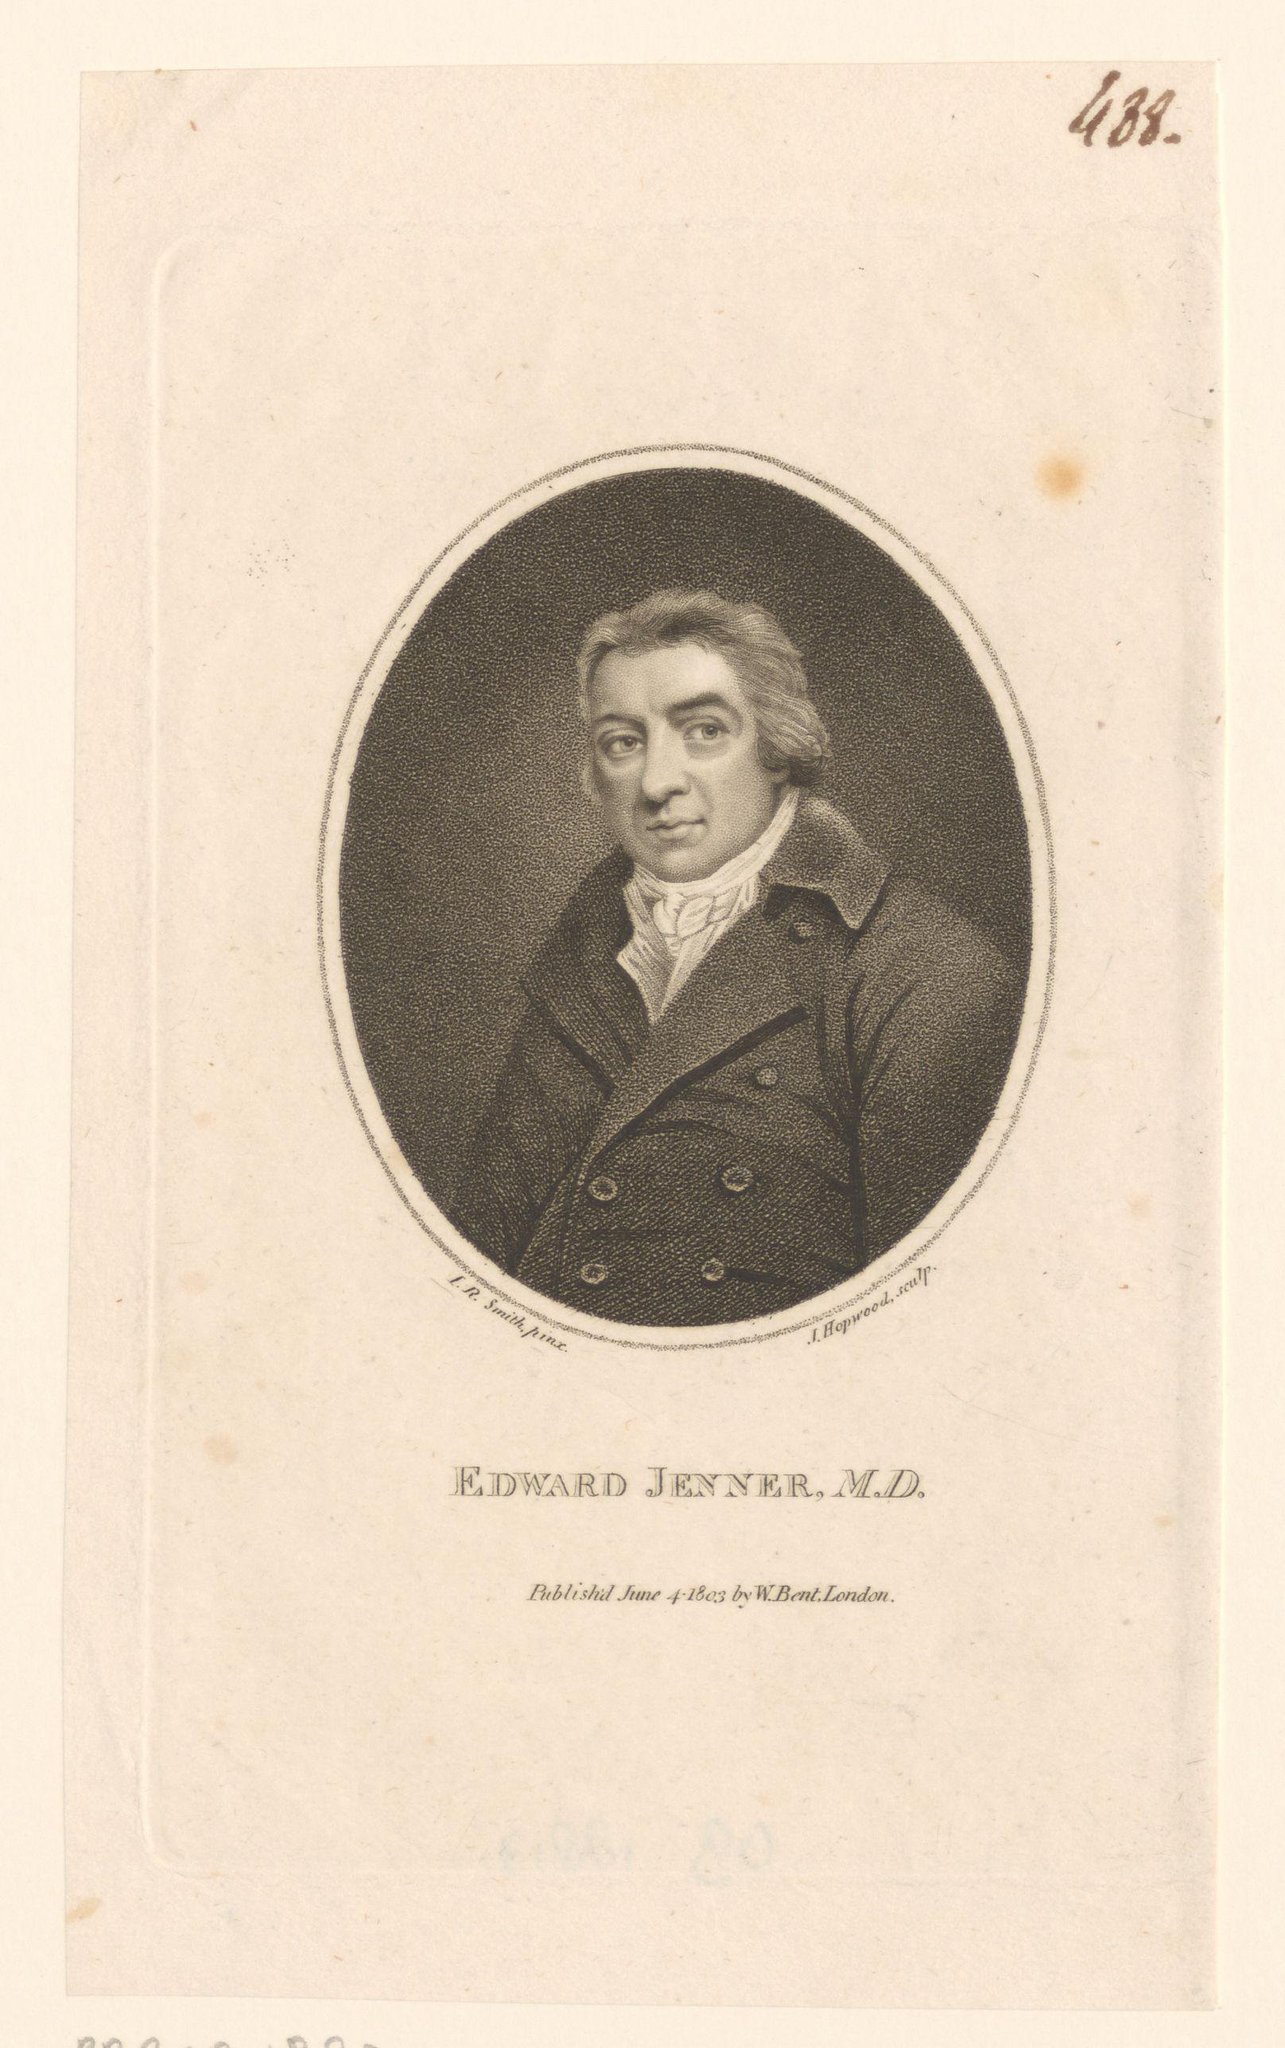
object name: print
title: Edward Jenner, M.D.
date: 1803-1806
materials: paper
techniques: etching, engraving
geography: england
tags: historical persons, physician, doctor (+ portrait of scholar, scientist)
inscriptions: collector's mark: Lugt 2228, inscription: ‘488’